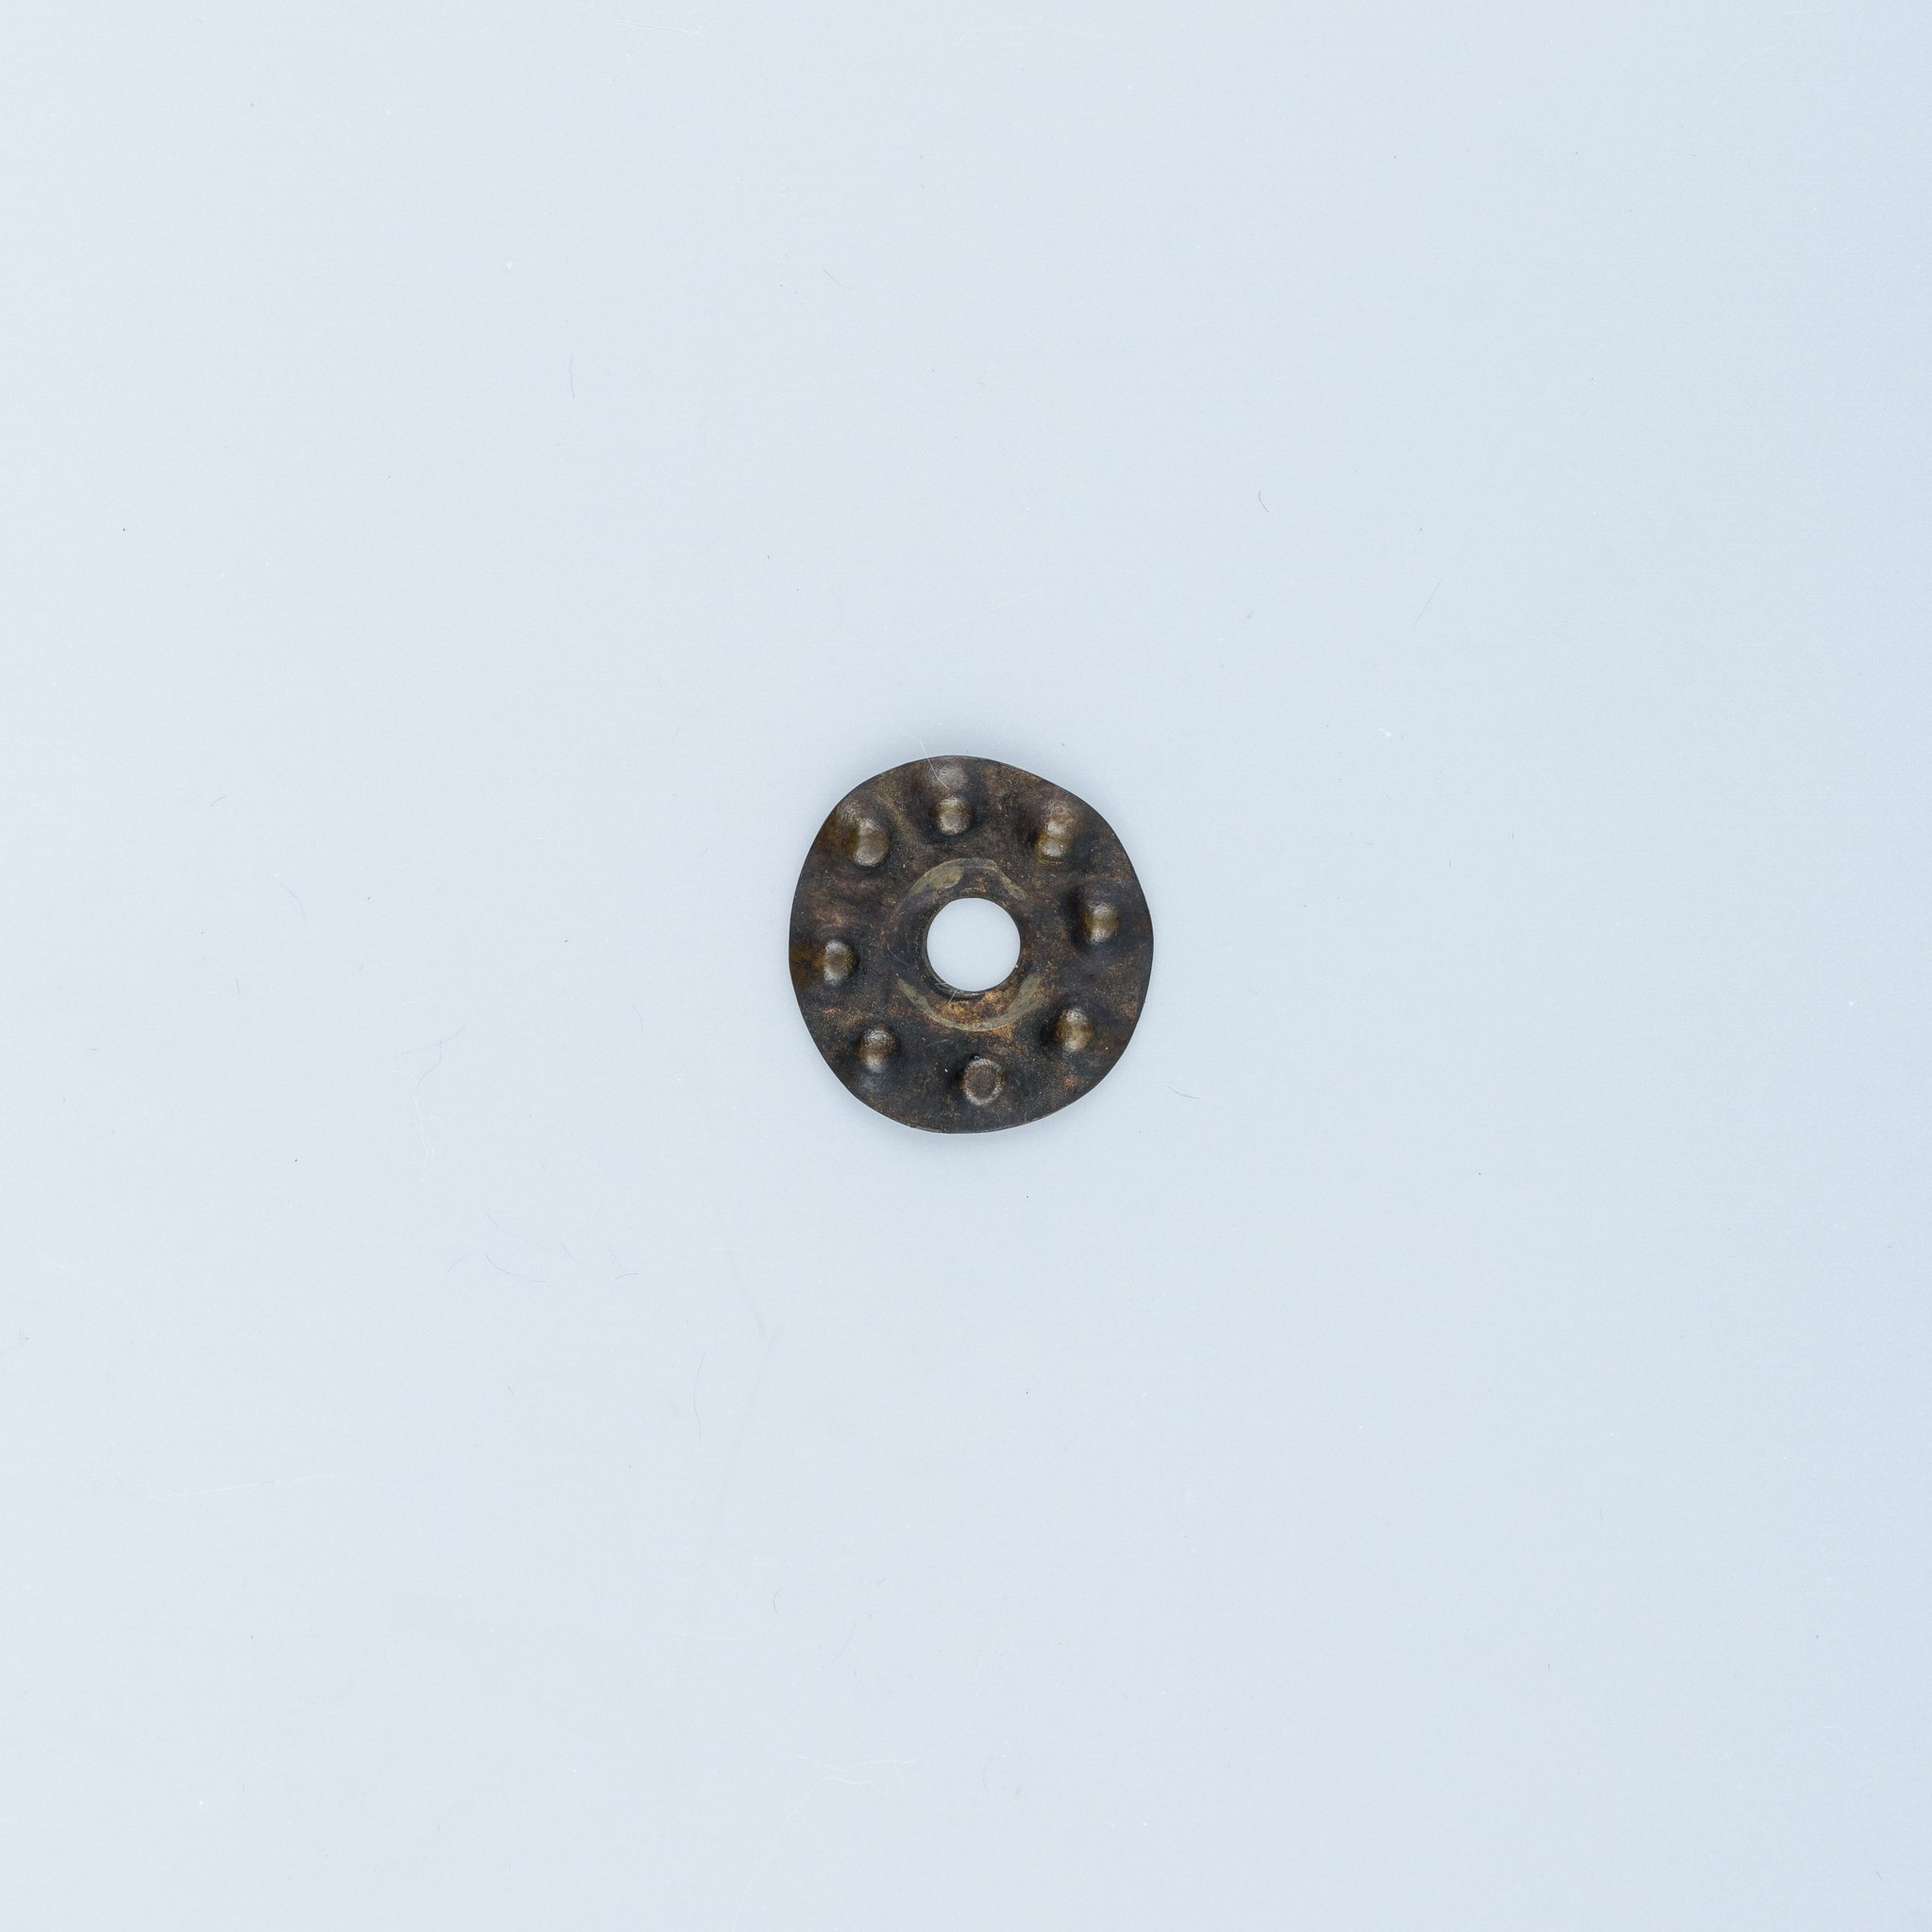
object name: rosette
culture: italian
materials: brass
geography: italy